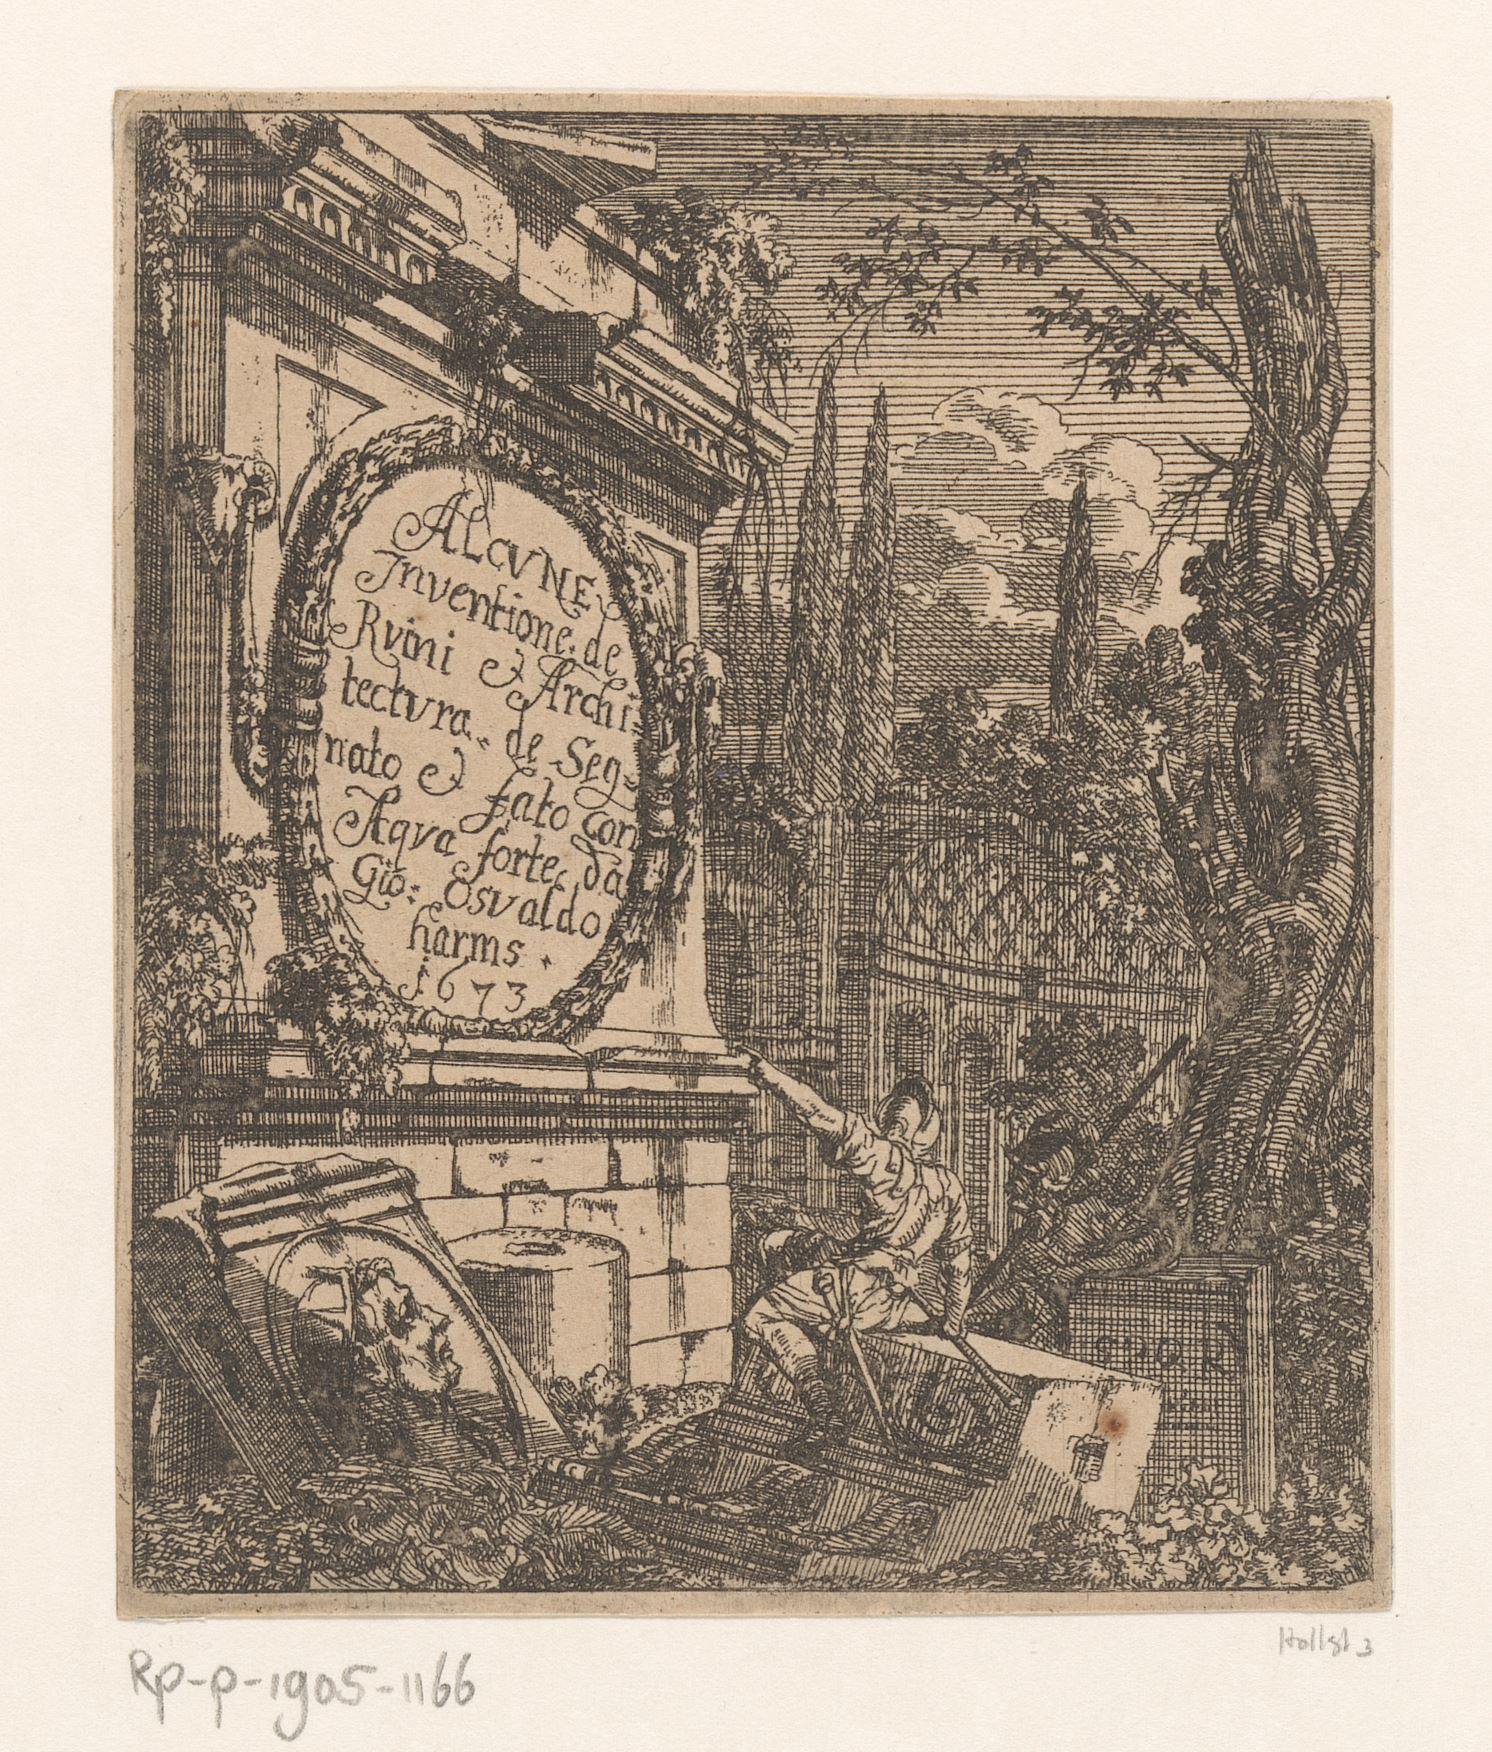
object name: titelprent, frontispice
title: Bewapend figuur wijst naar een monument in een landschap met Romeinse ruïnes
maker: johann oswald harms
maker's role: print maker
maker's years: 1643-1708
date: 1673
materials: paper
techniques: etching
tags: trees: cypress, landscape with ruins (+ city(-scape) with figures, staffage)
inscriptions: collector's mark: Lugt 2228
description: Onderdeel van een serie van negen prenten.